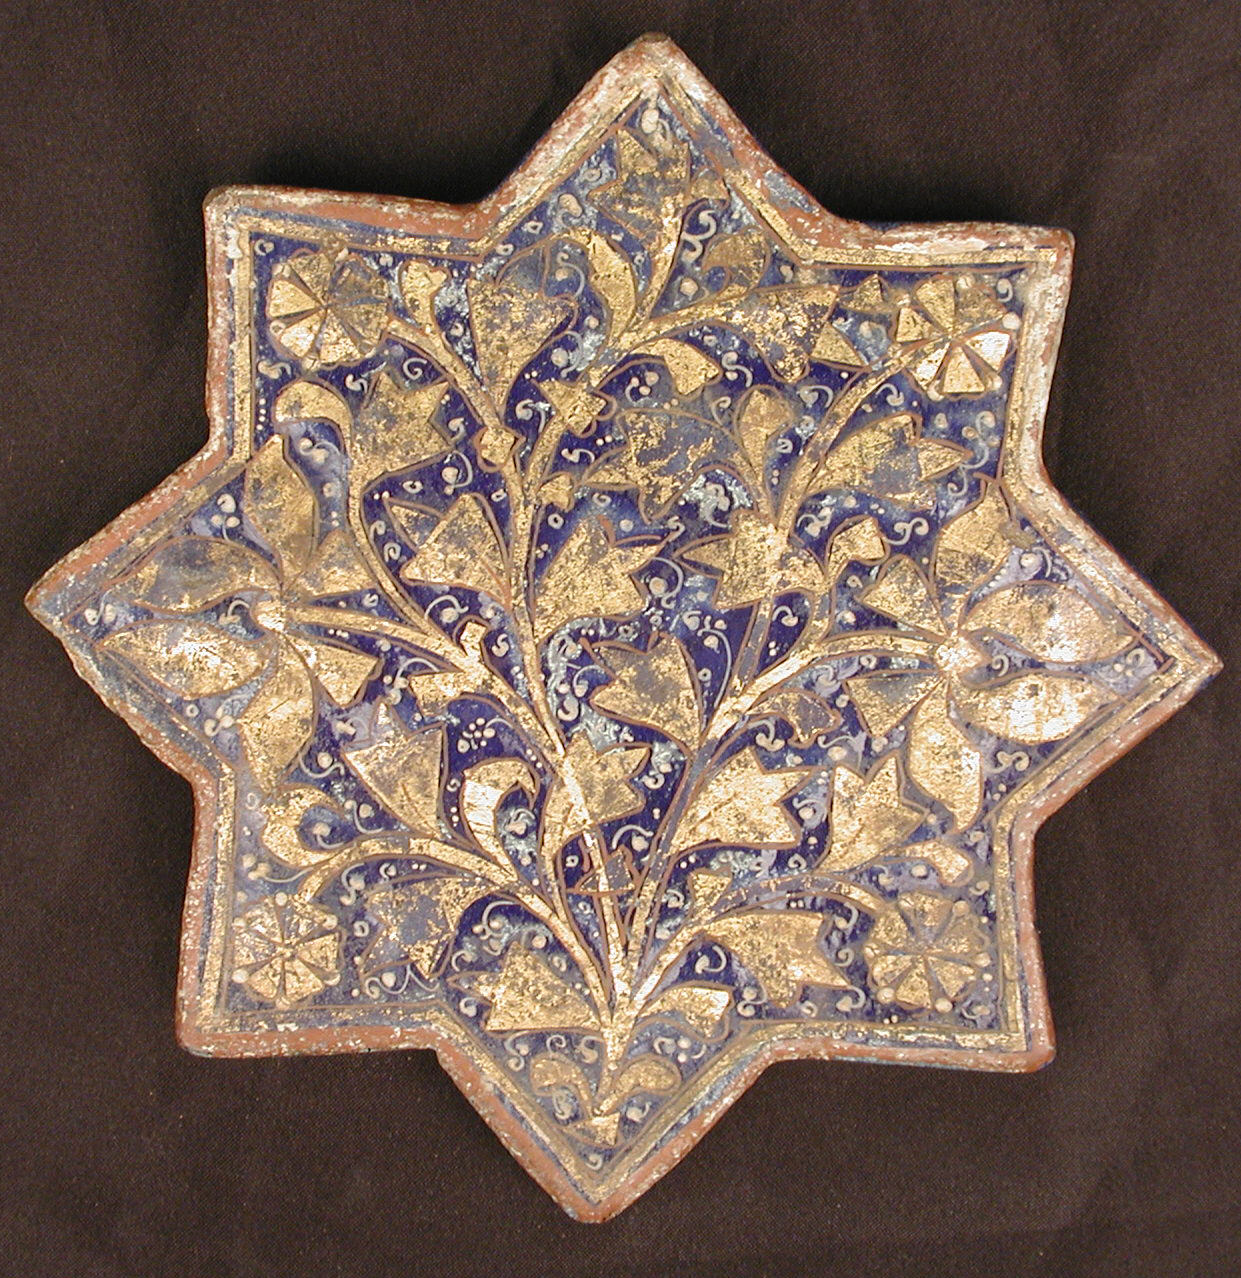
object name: star shaped tile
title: Three Tiles with 'Lajvardina' Glaze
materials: stonepaste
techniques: gilding, molding, overglaze, painting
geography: iran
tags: flowers,leaves